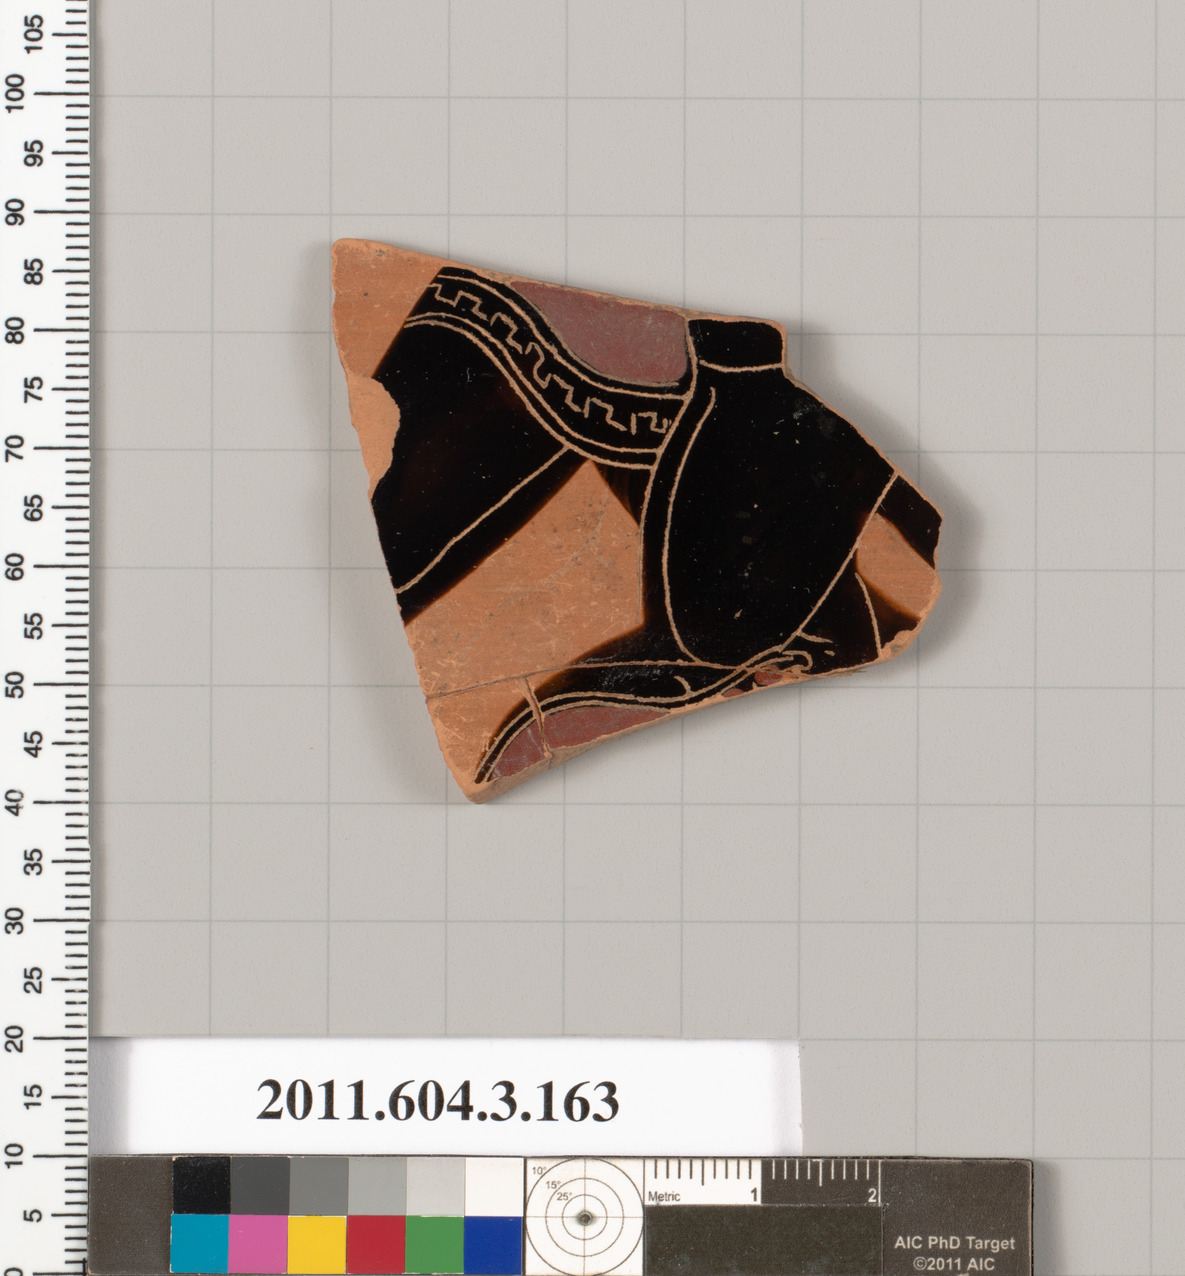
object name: amphora fragment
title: Terracotta fragment of an amphora (jar)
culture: greek, attic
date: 550-540 BCE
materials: terracotta